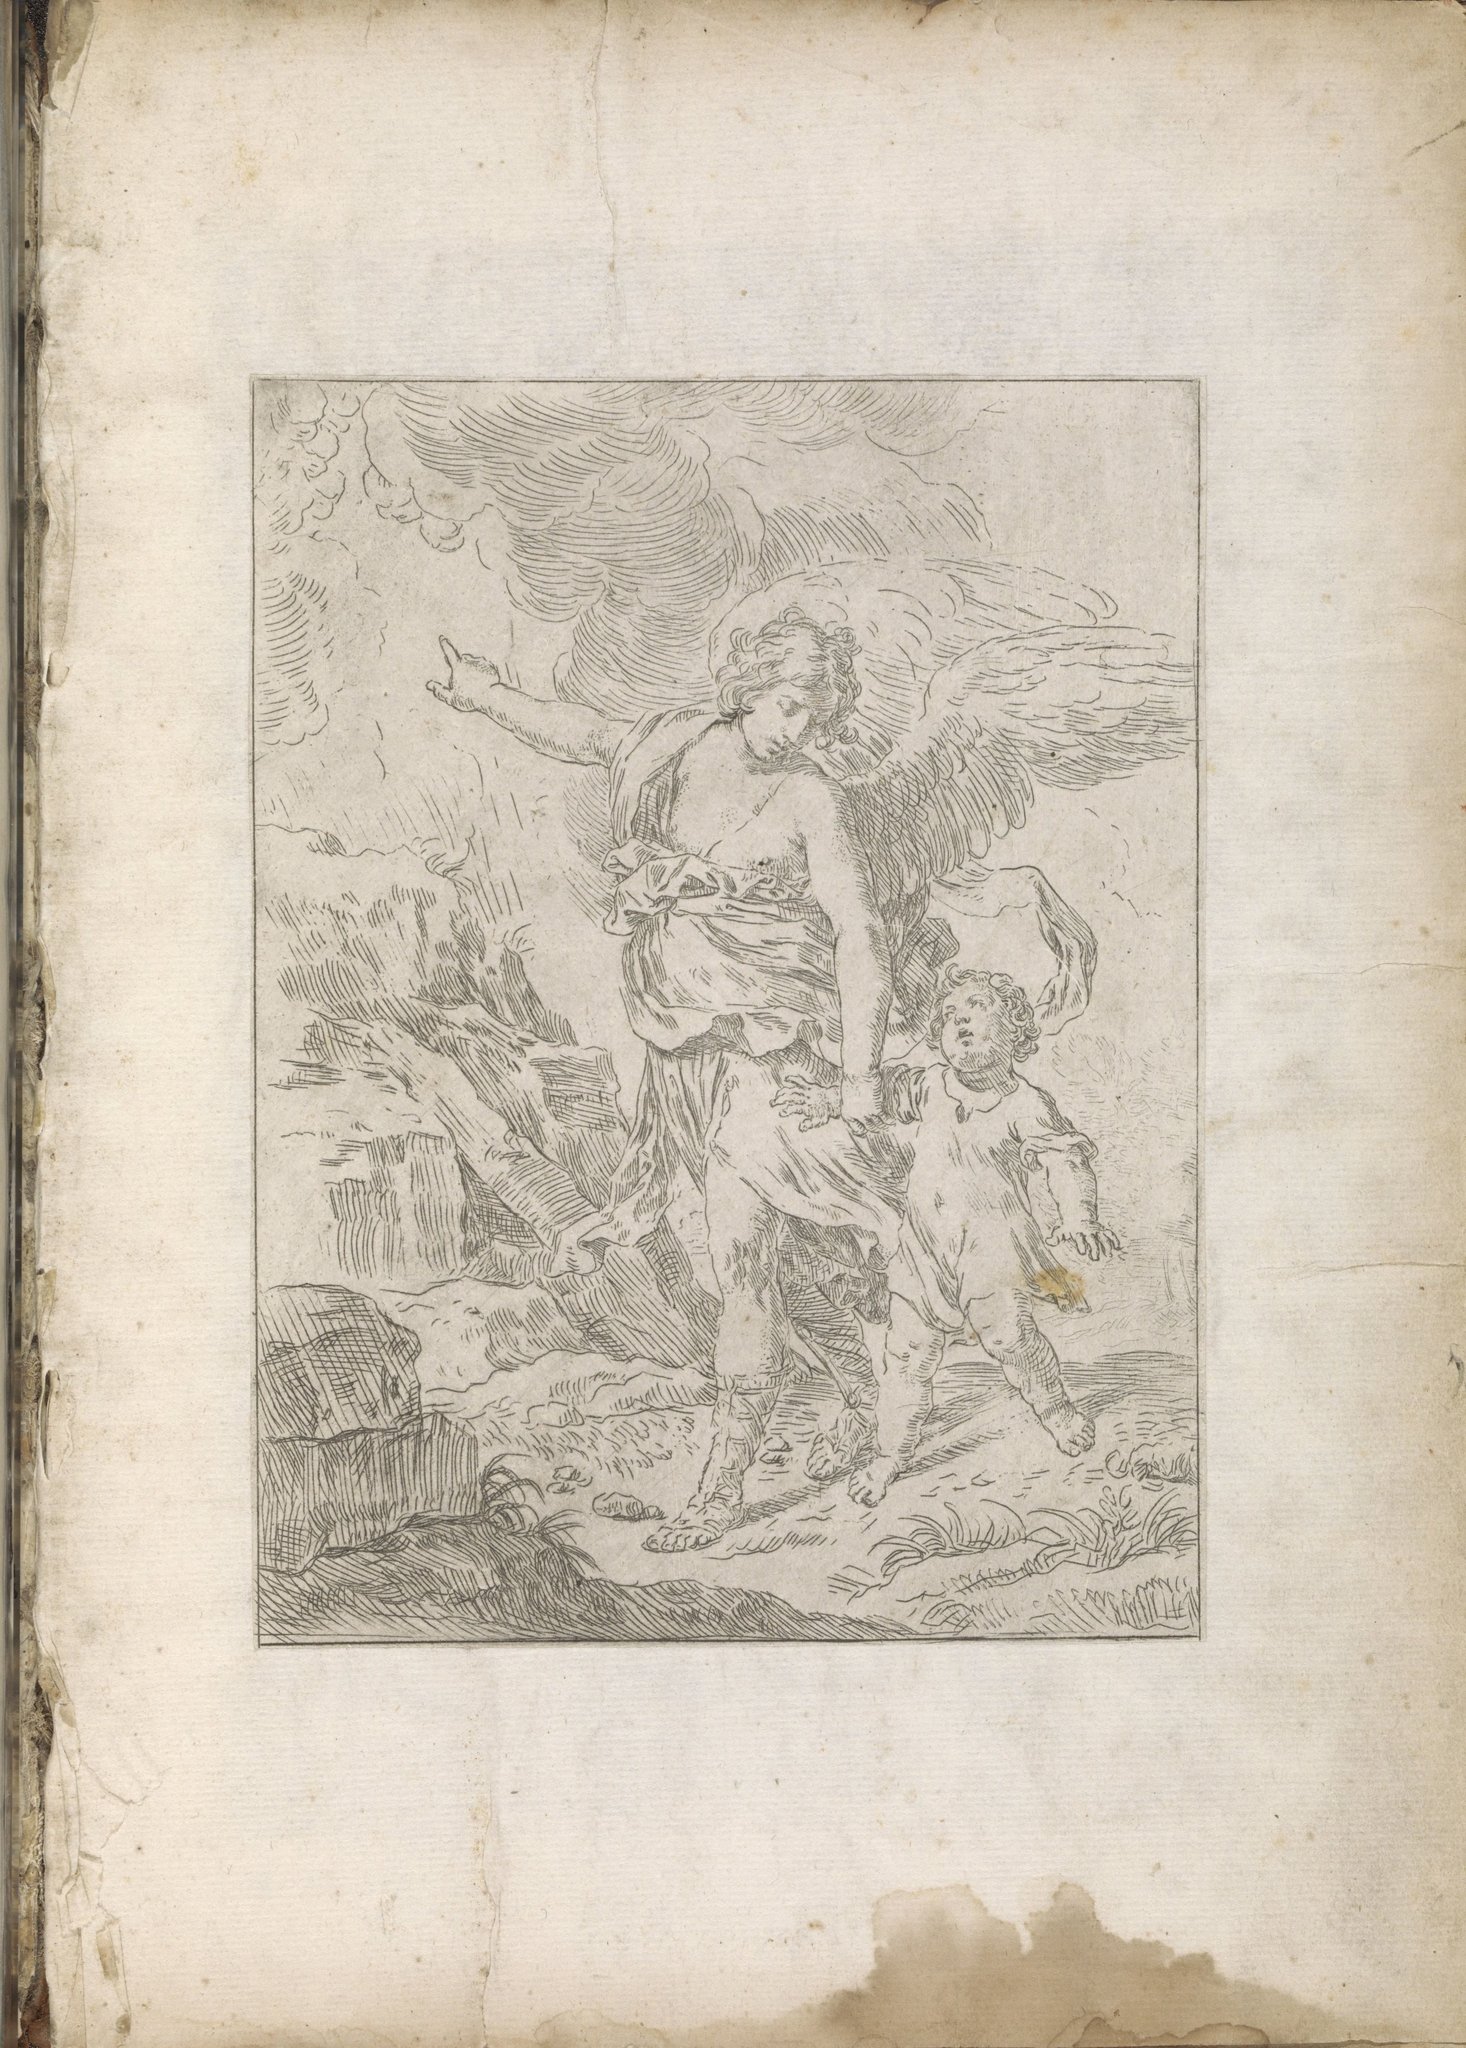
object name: print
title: Engel neemt kind bij de hand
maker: Anonymous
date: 1600-1700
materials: paper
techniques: etching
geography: low countries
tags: child, guardian angel, index finger forwards, pointing, indicating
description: Een engel neemt een kind bij de arm en wijst hem op de hemel. Prent maakt deel uit van een album.